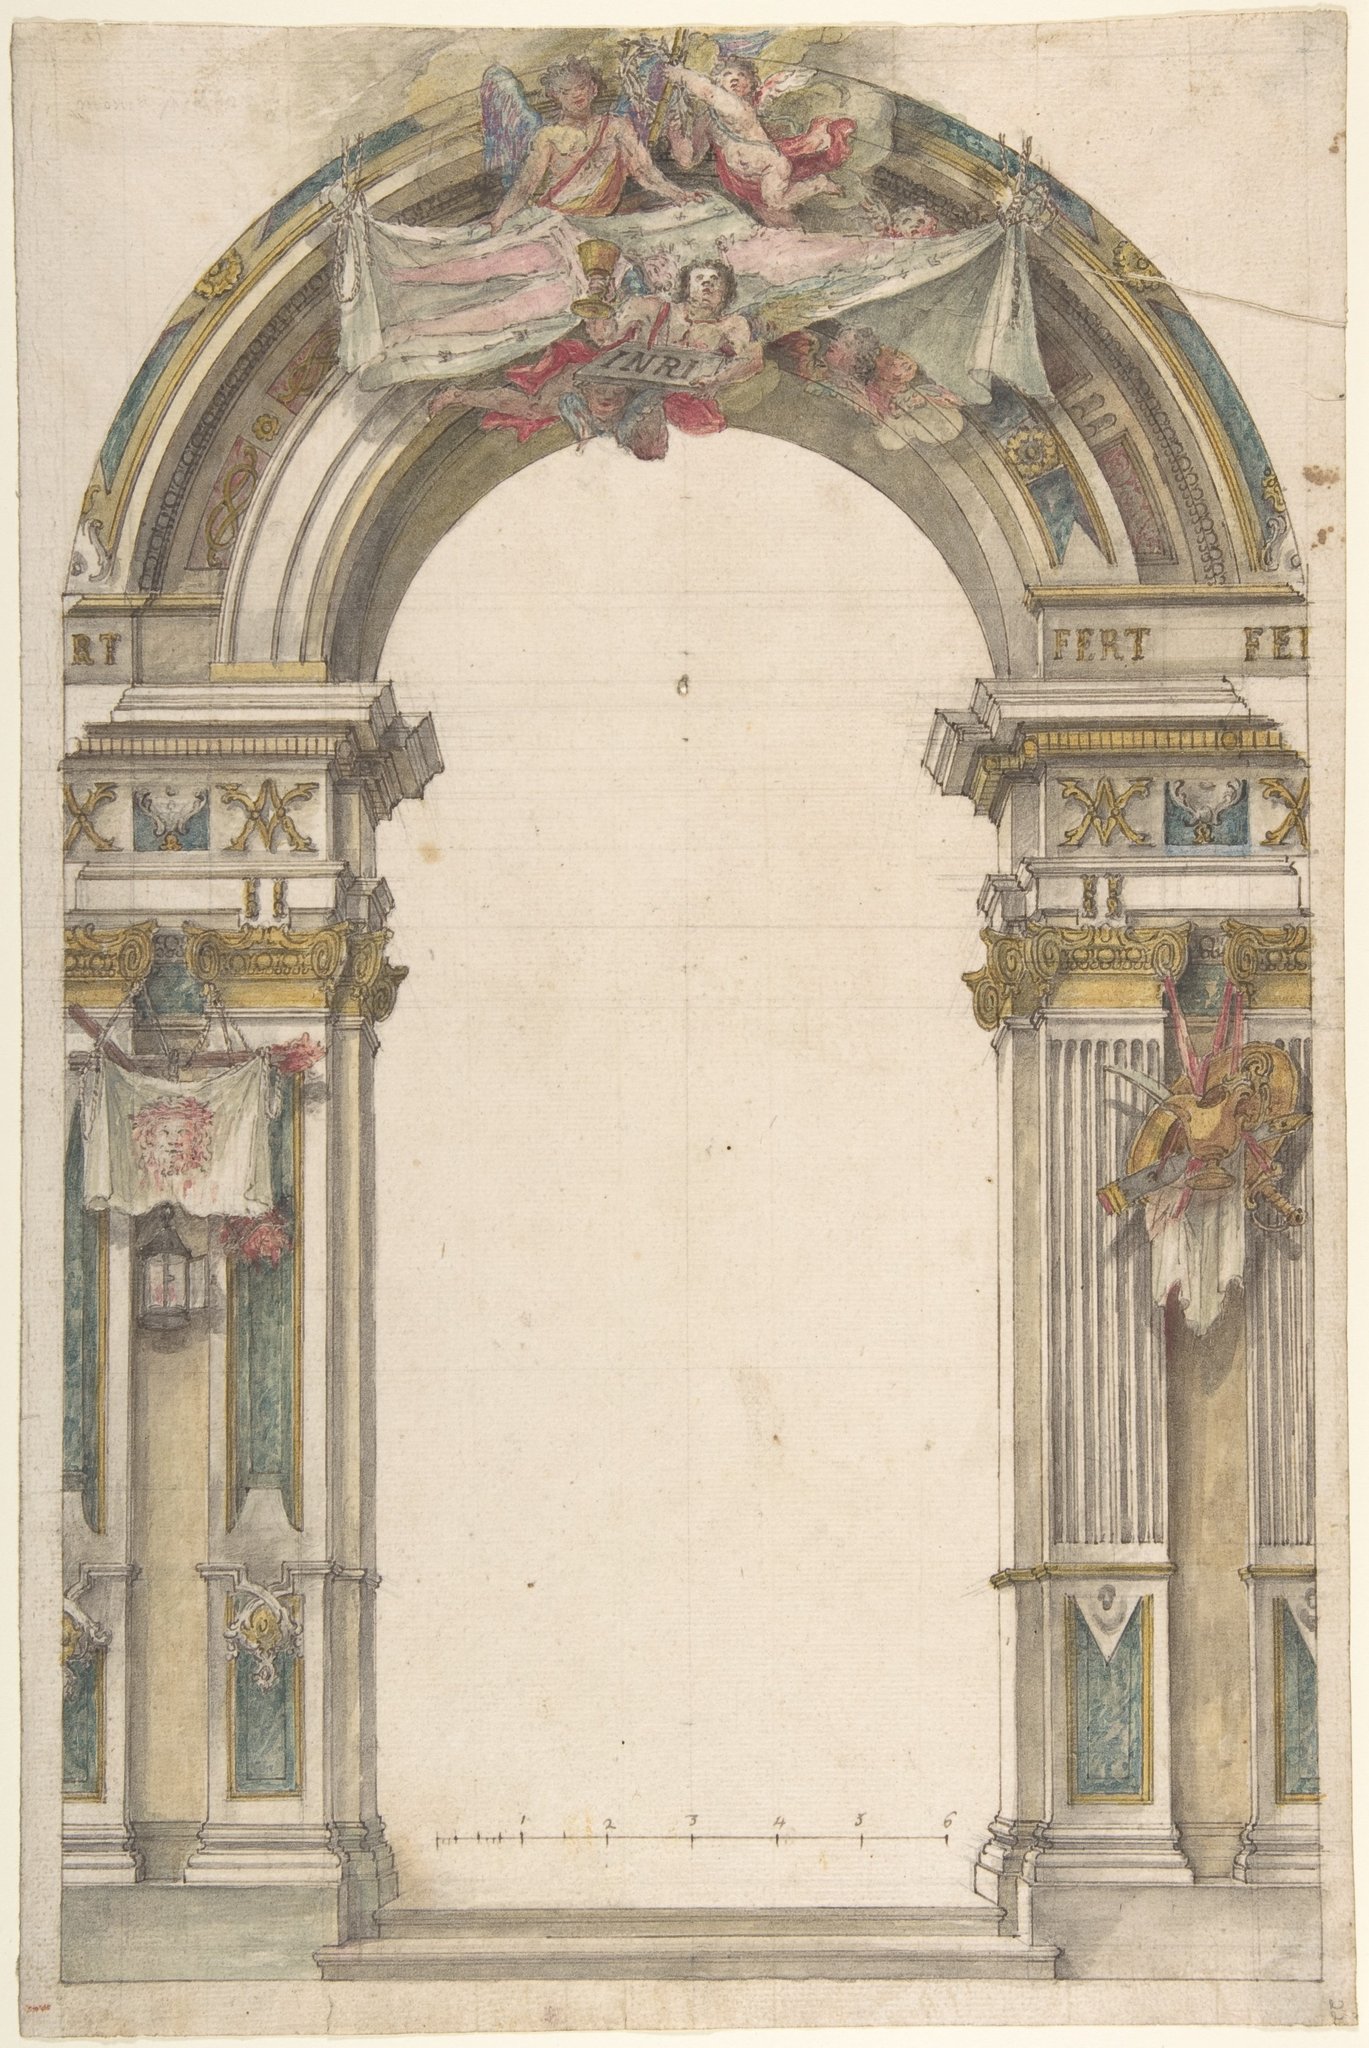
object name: drawing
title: Design for the Entrance to a Chapel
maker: anonymous, italian, piedmontese, 18th century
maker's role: artist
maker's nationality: italian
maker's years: 1700-1800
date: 1700-1780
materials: ink, drawing material, watercolor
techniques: brush, pen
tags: architecture,arches,angels